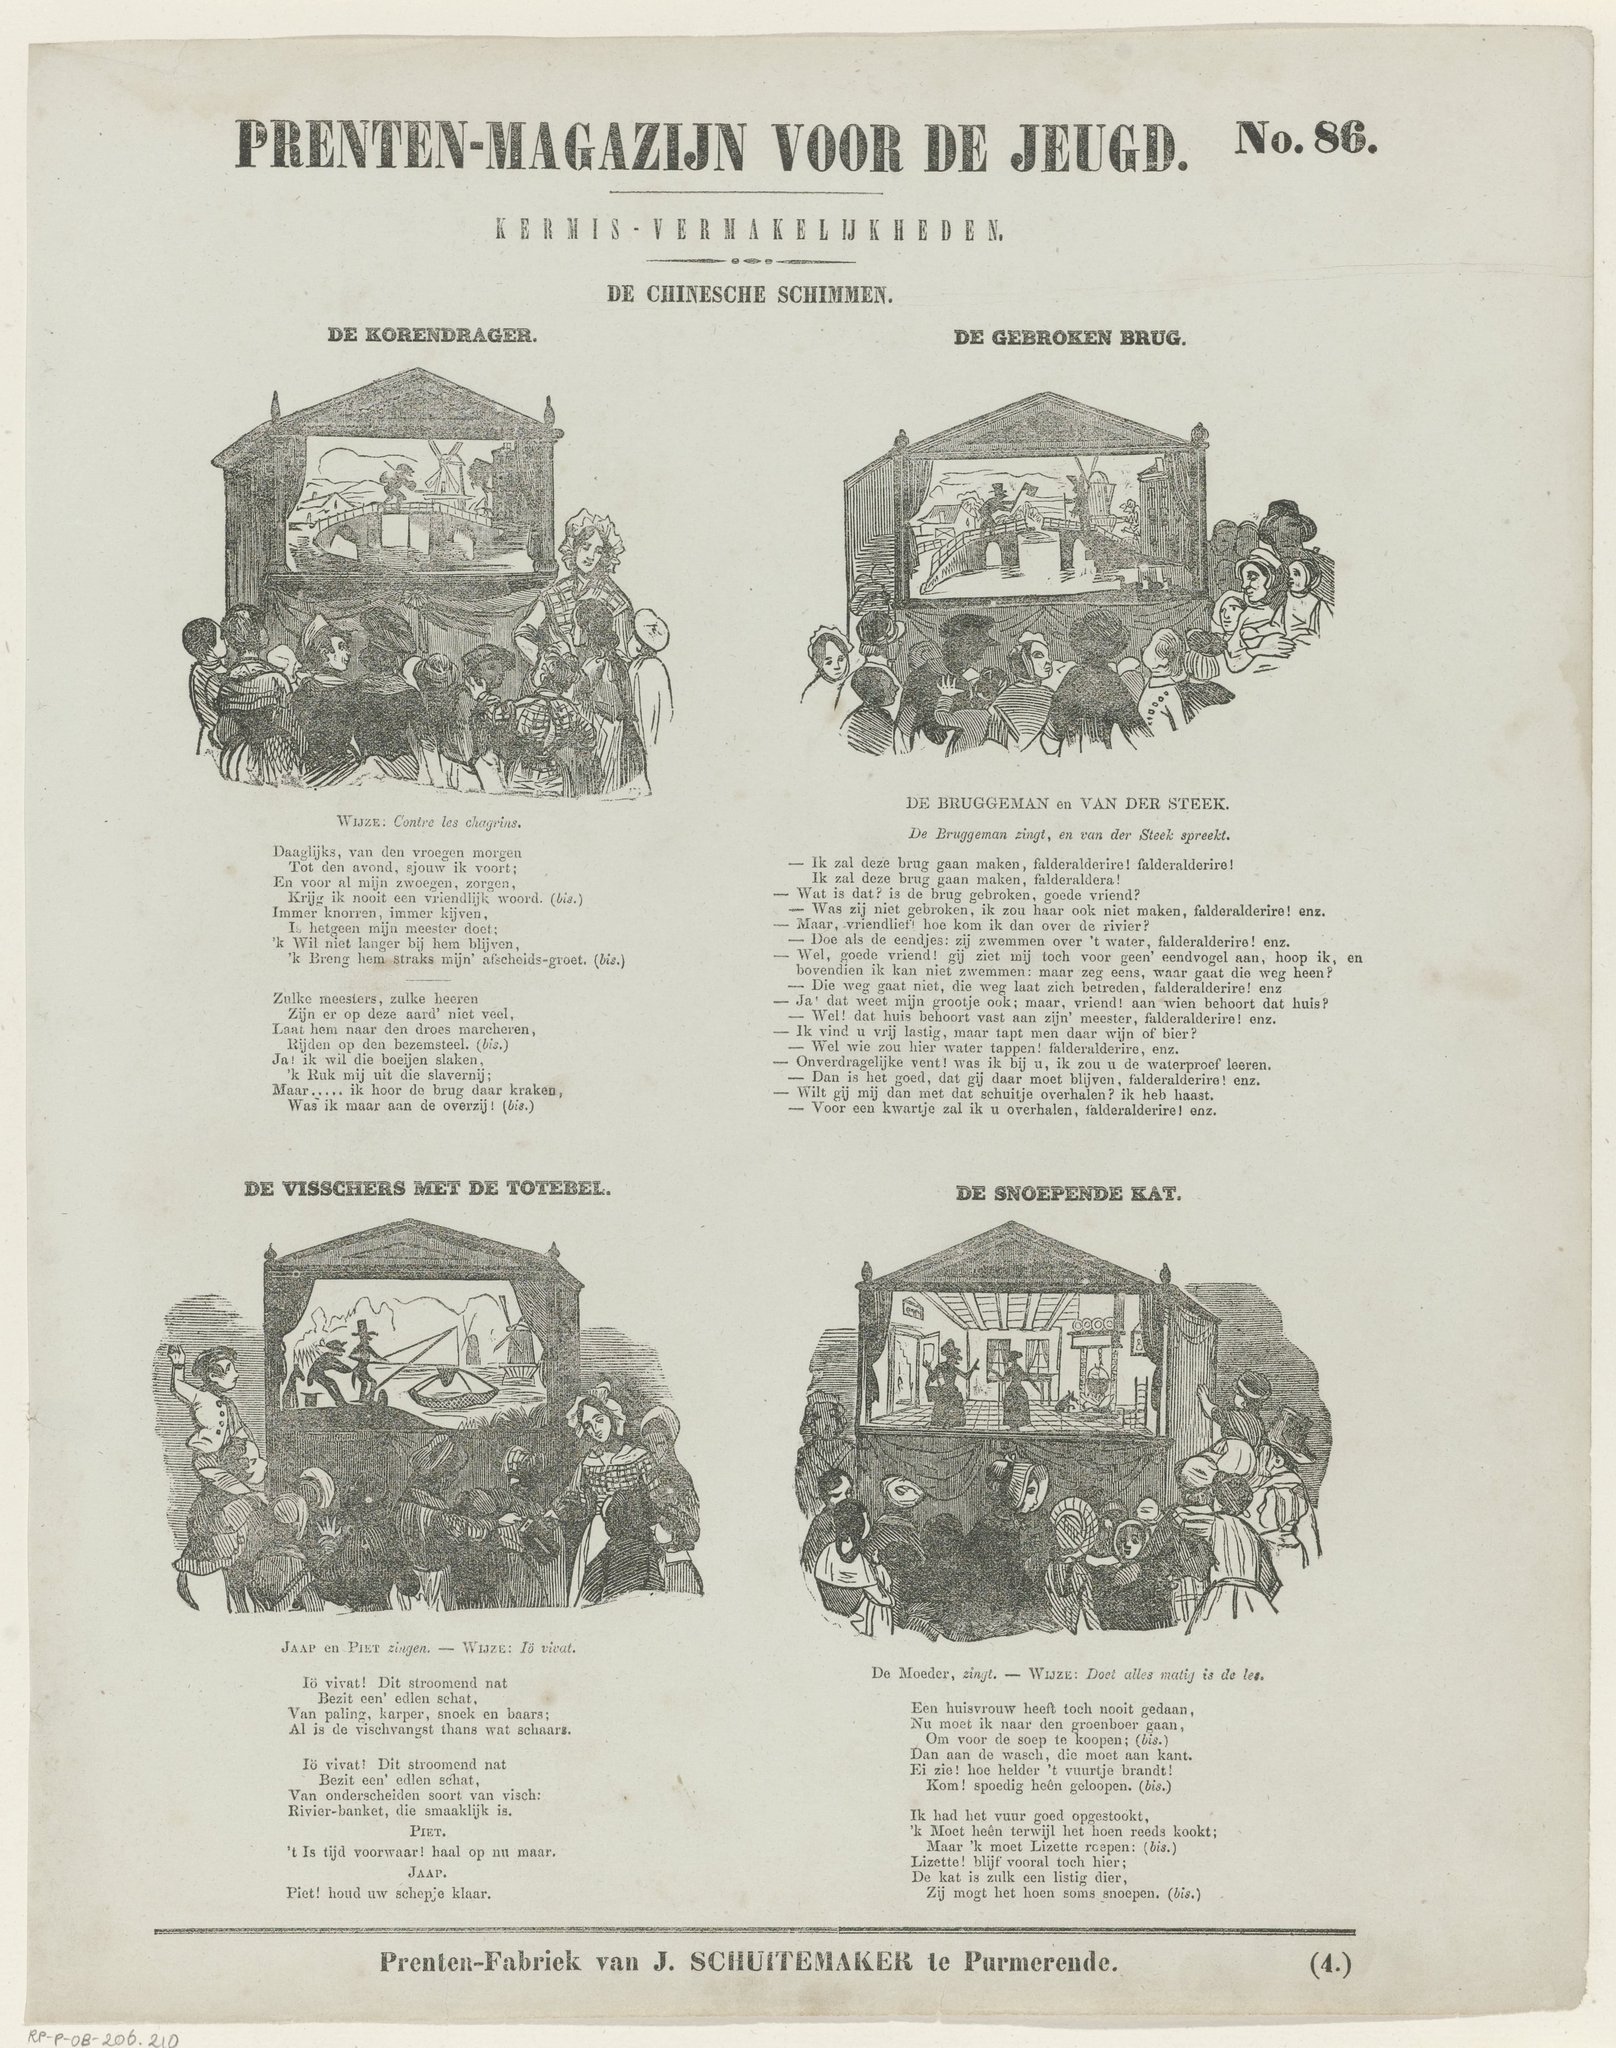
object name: print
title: Prenten-magazijn voor de jeugd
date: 1850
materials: paper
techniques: letterpress printing, engraving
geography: purmerend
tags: shadow-play, shadow pictures (~ hand games)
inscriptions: collector's mark: Lugt 2760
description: Na voltooiing van de acht jaargangen van de reeks 'Prenten-magazijn voor de jeugd' in 1850 heeft Jan Schuitemaker al deze prenten heruitgegeven en omgenummerd als nr. 1 t/m 192. De oorspronkelijke jaargang wordt telkens nog vermeld rechtsonder op de prent. Binnen de jaargangen zijn prenten van hetzelfde thema in clusters van vier achter elkaar gezet.